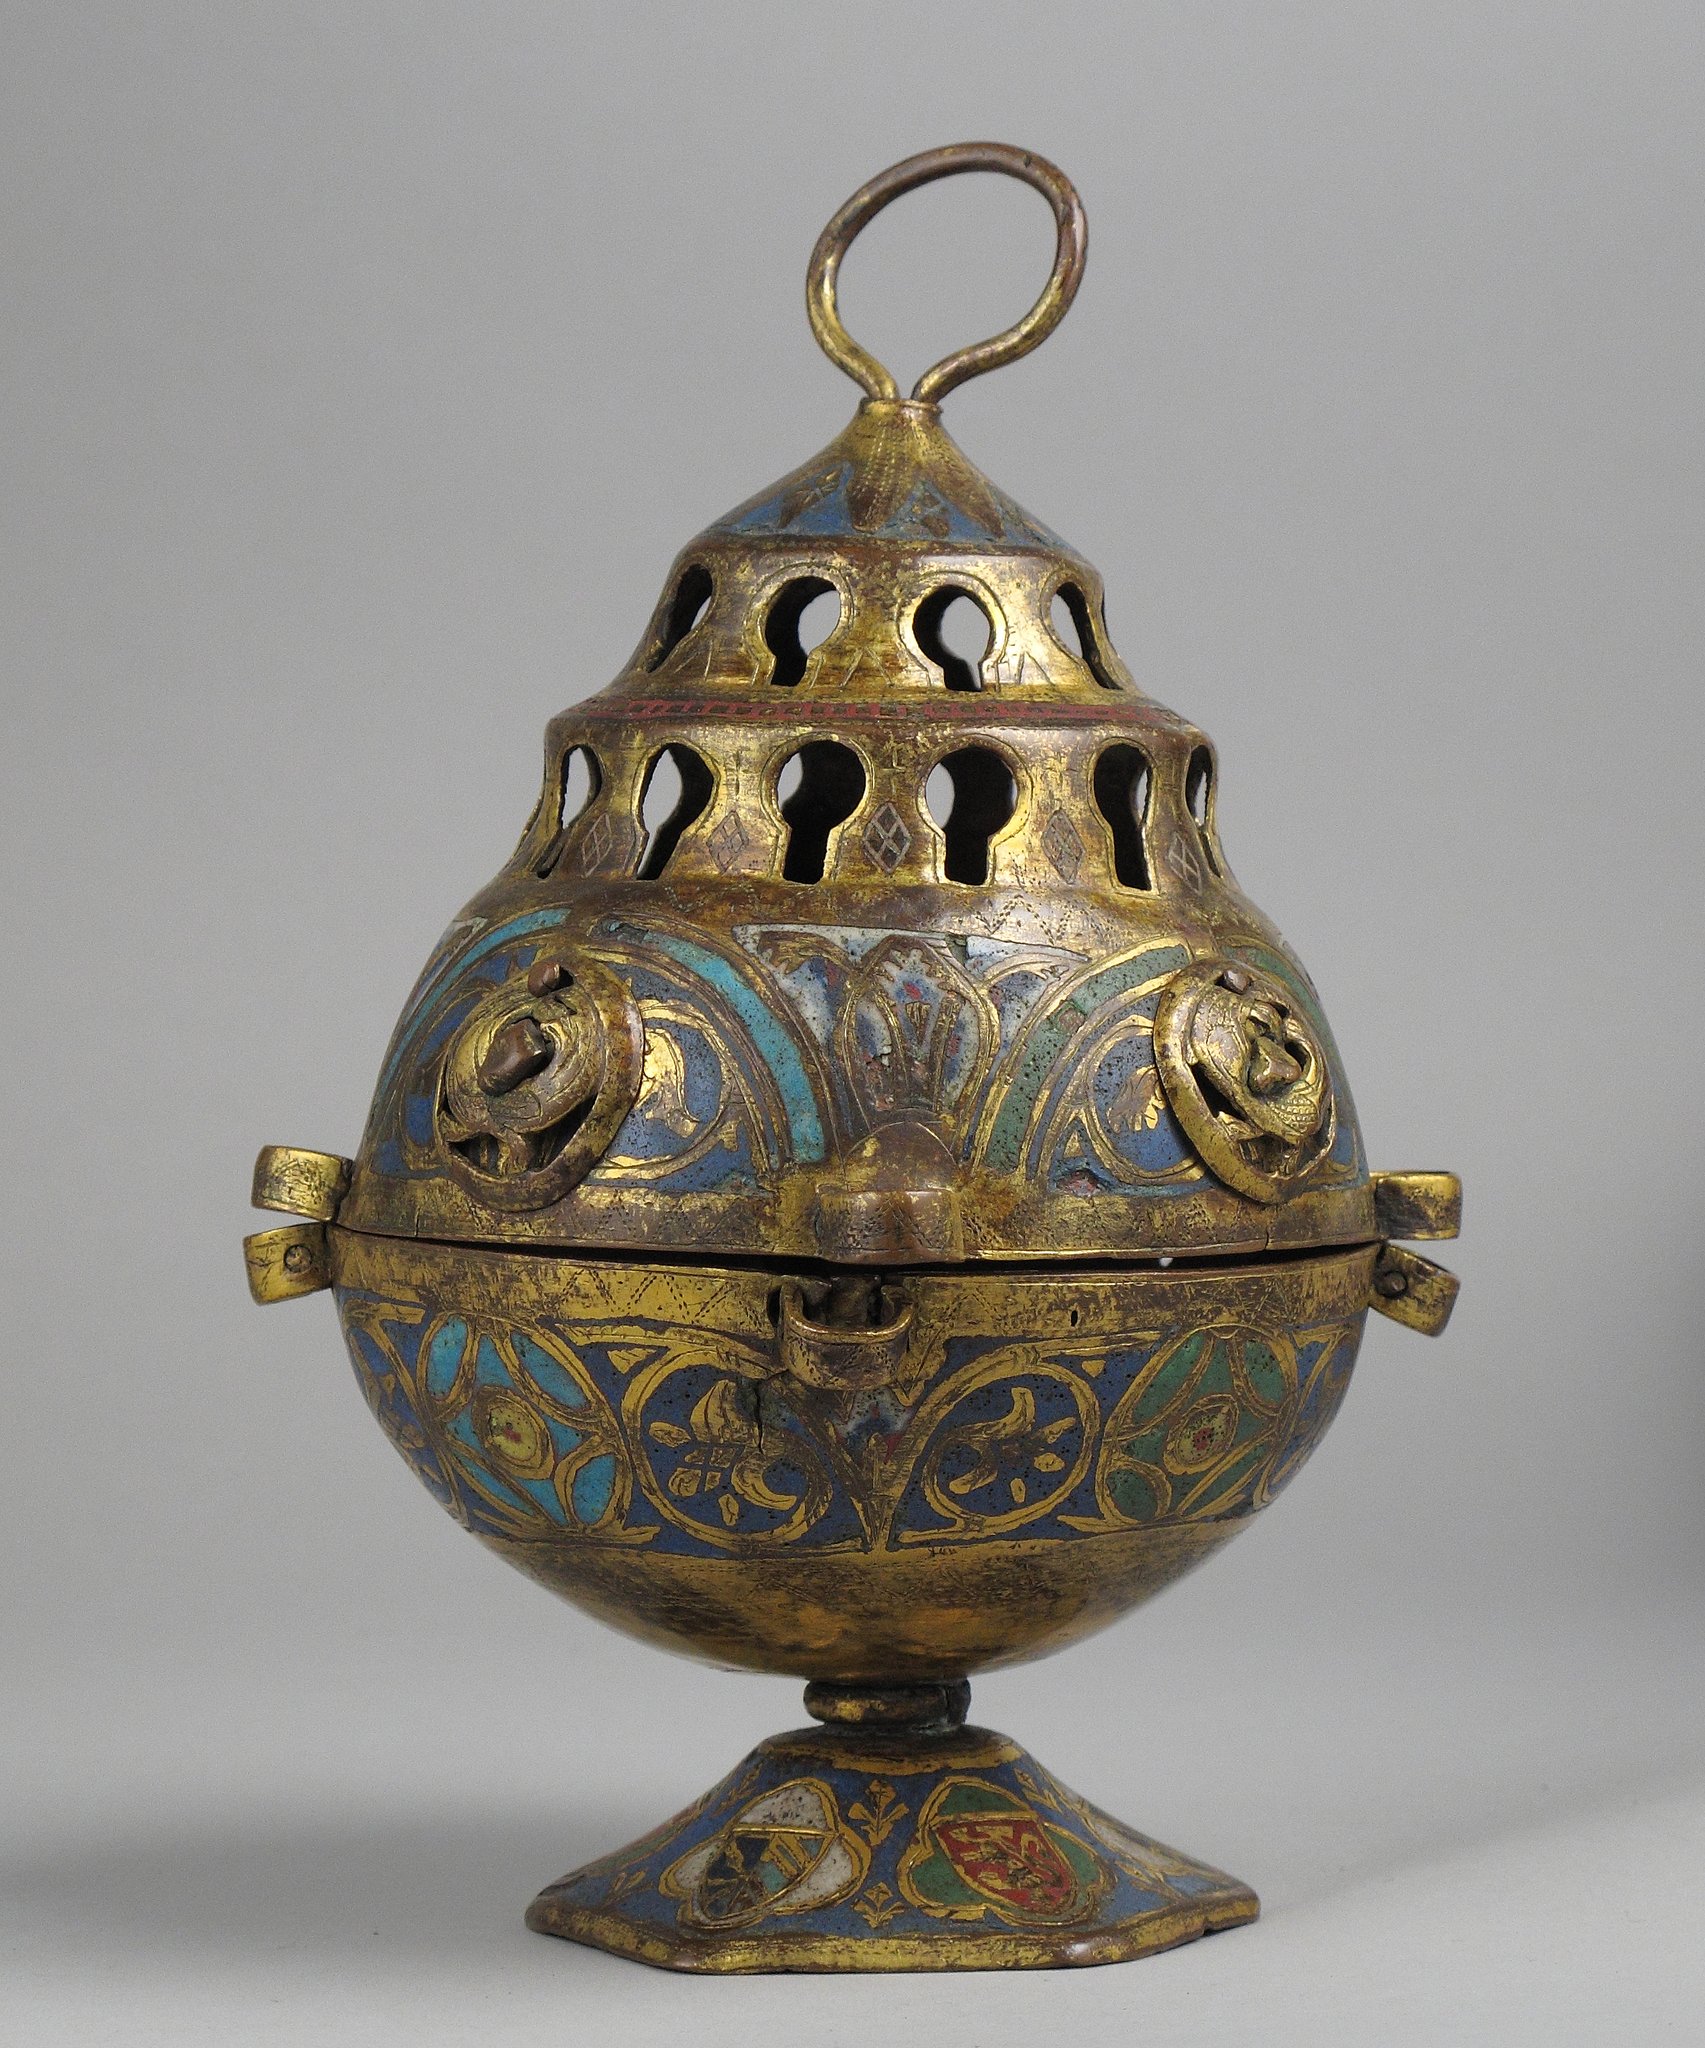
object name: censer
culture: french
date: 1201-1300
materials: copper, enamel, gilt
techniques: enamel, engraving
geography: france